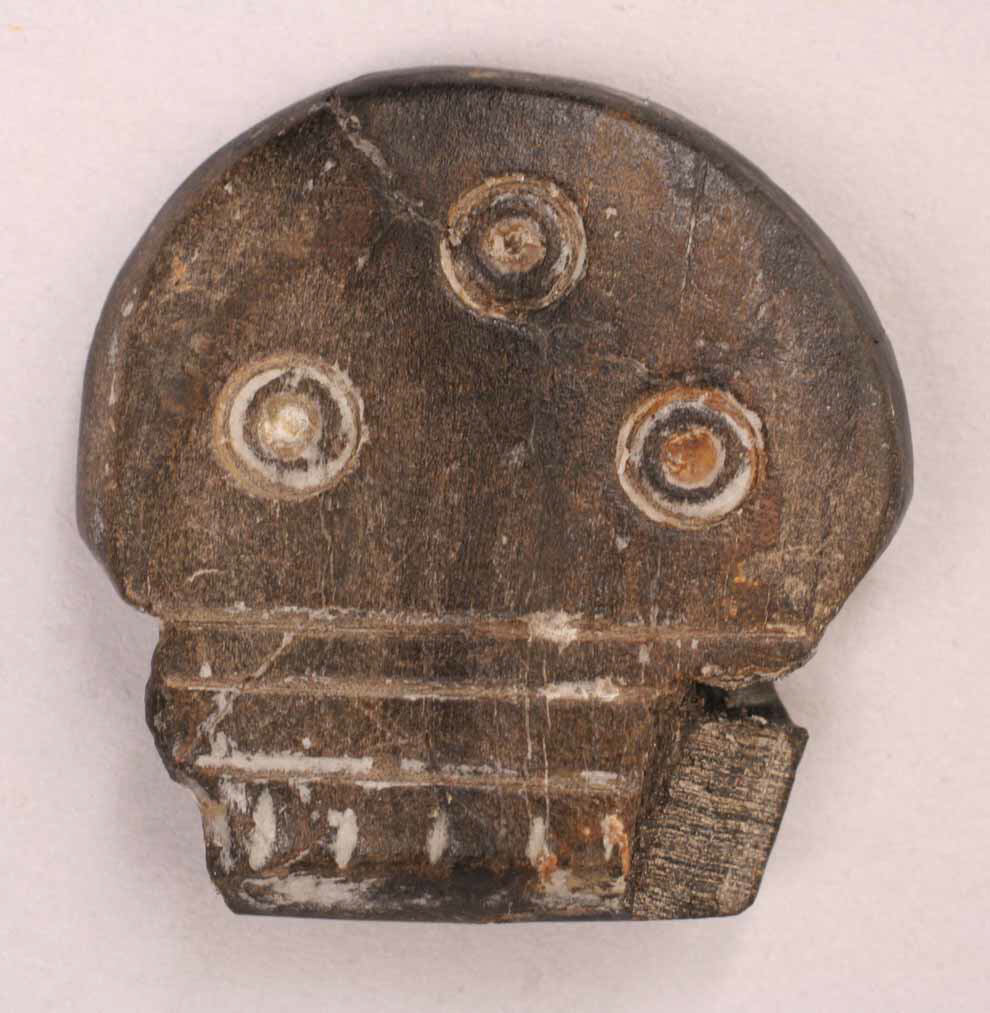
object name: jewellery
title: Jewelry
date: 701-1200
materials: bone, stone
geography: iran